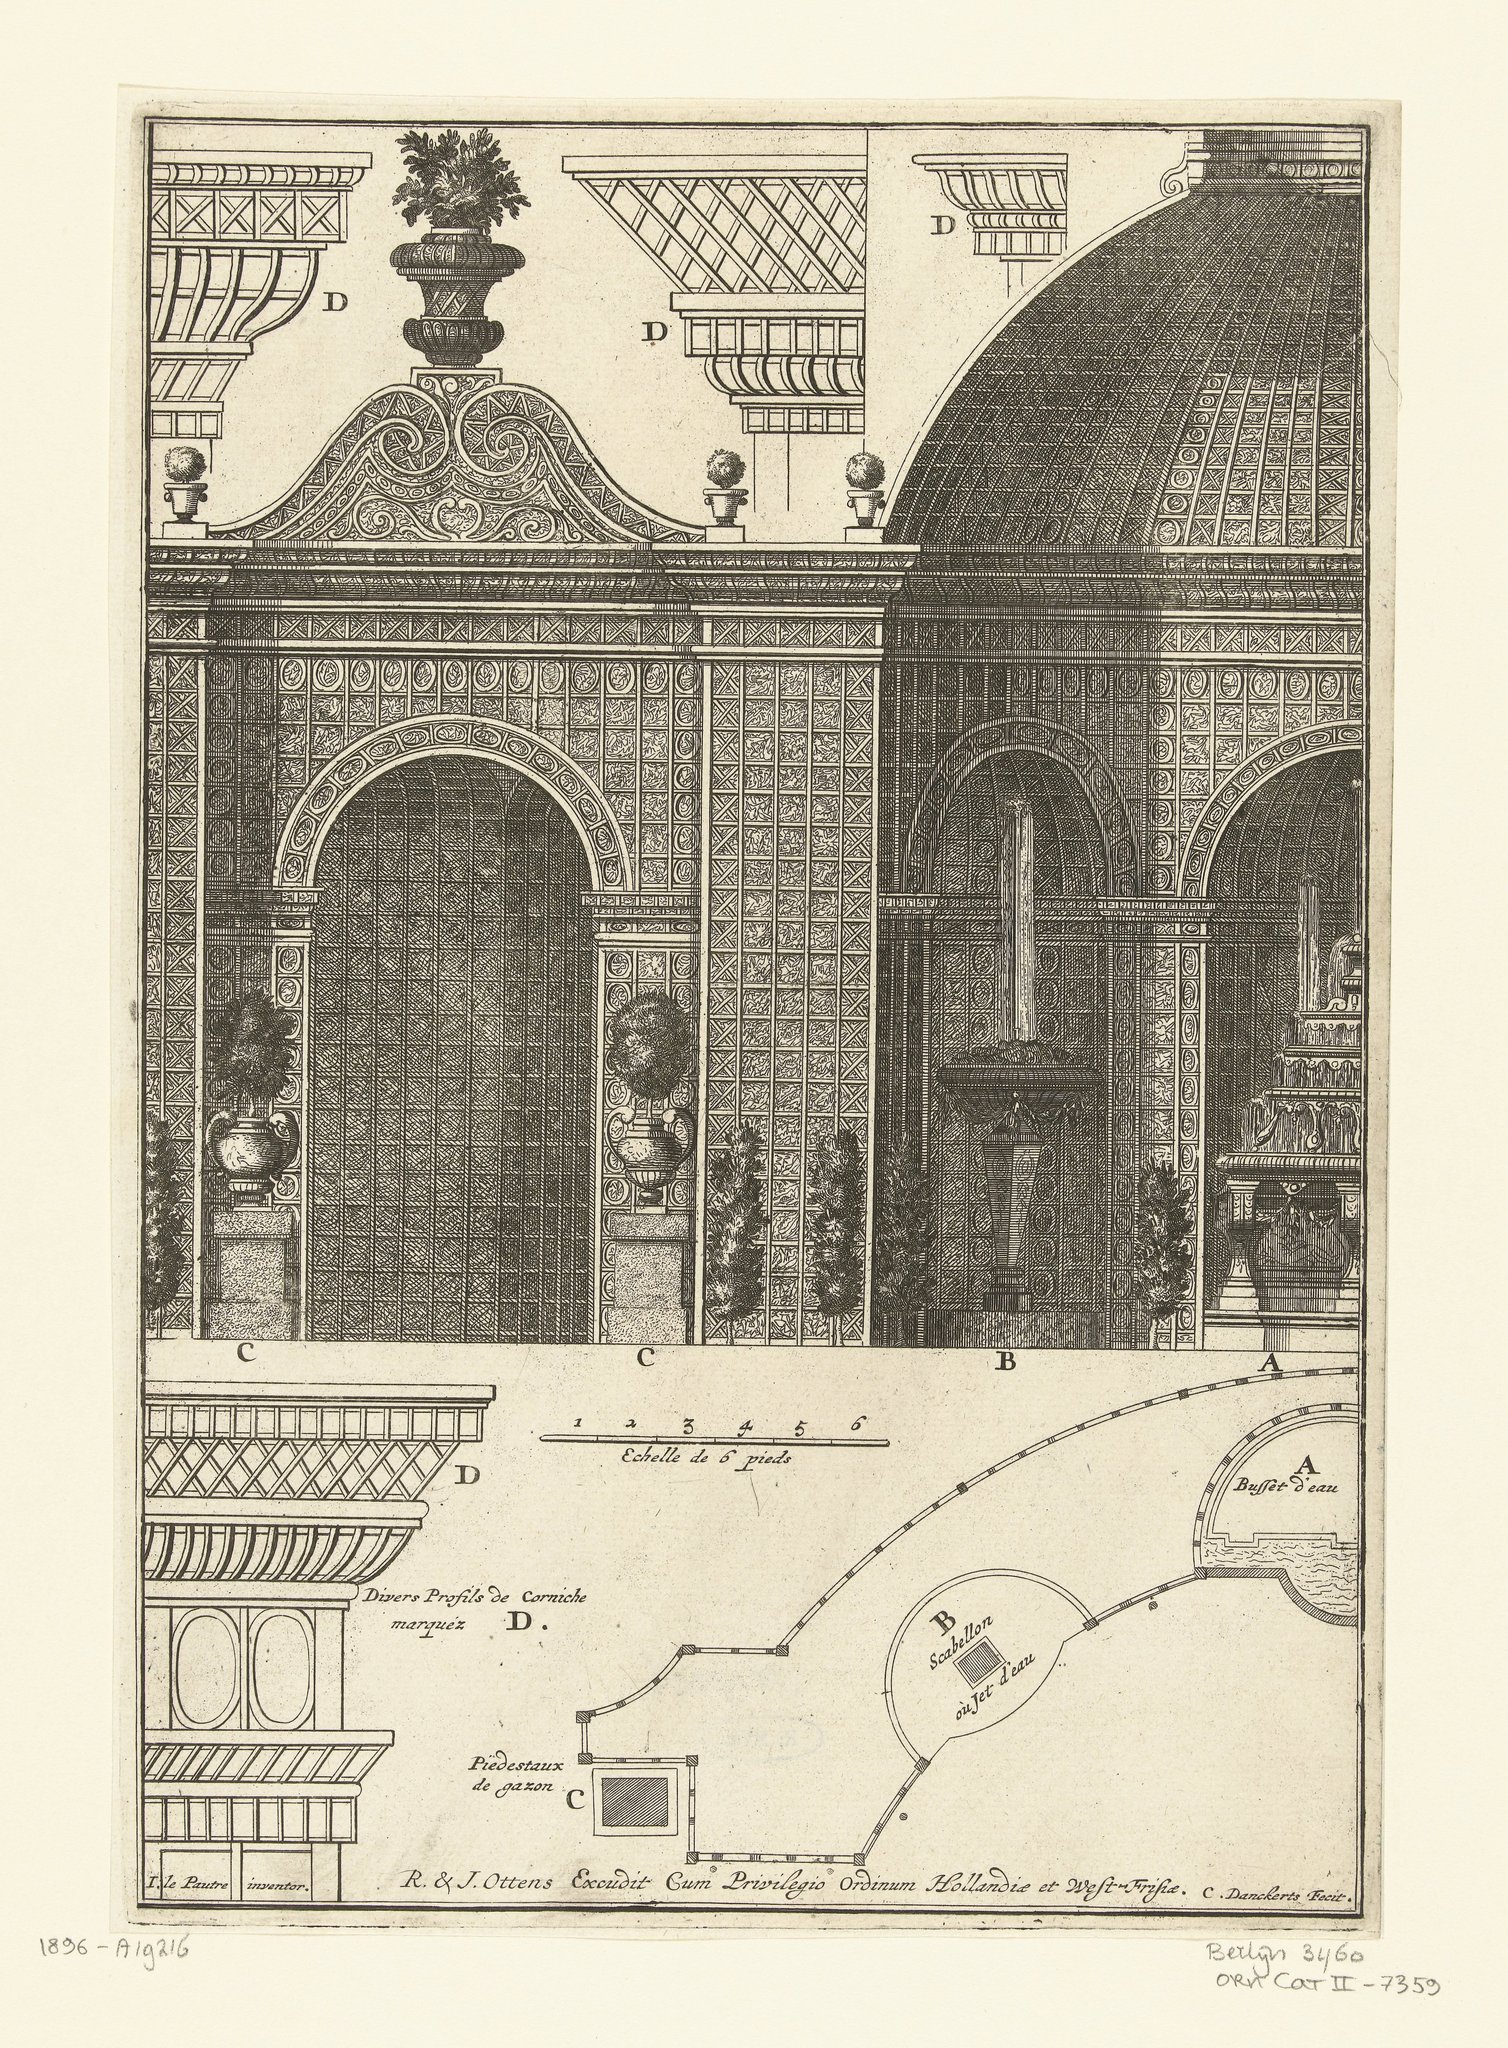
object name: print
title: Latwerkpaviljoen met waterbuffet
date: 1726-1750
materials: paper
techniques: etching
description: Met opstand en plan, met vier details van het kroonelement. Uit serie van 6 bladen, latere editie dan de serie met latwerkpaviljoens uitgegeven door Justus Danckerts. Tweede afdruk.